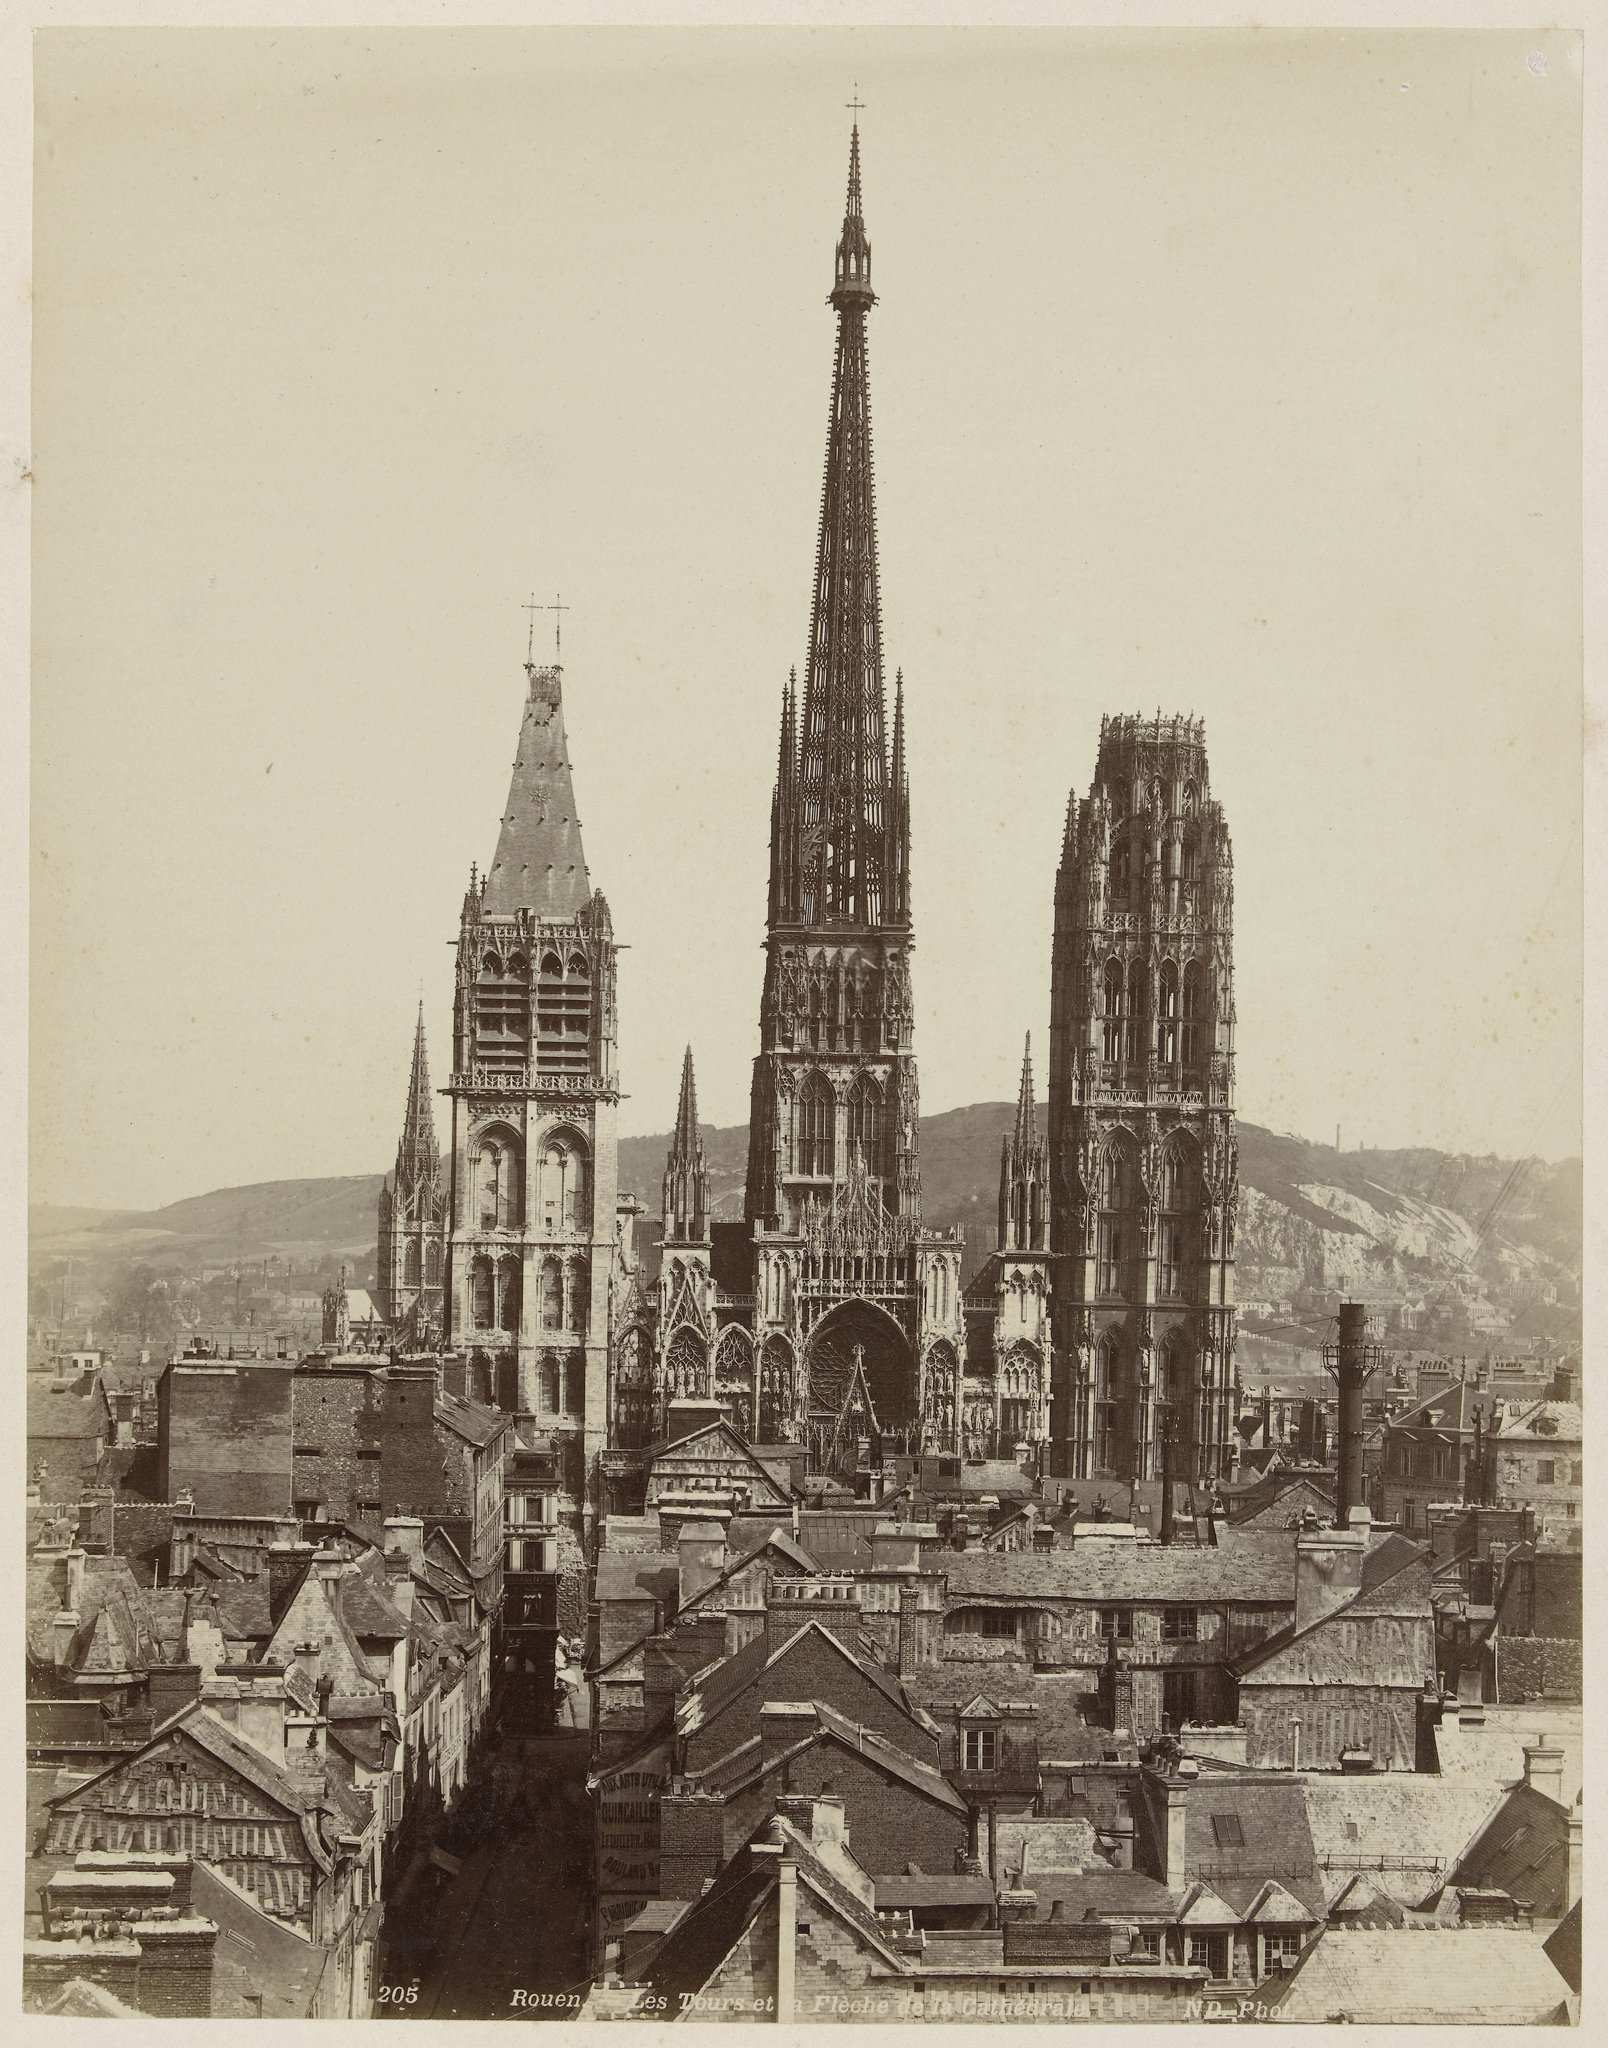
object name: photograph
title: Rouen - Les Tours et la Flèche de la Cathédrale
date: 1863-1900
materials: cardboard, paper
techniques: albumen print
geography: rouen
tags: church (exterior), parts of church exterior and annexes: tower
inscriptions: inscription: ‘205 Rouen - Les Tours et la Flèche de la Cathédrale ND. Phot.’